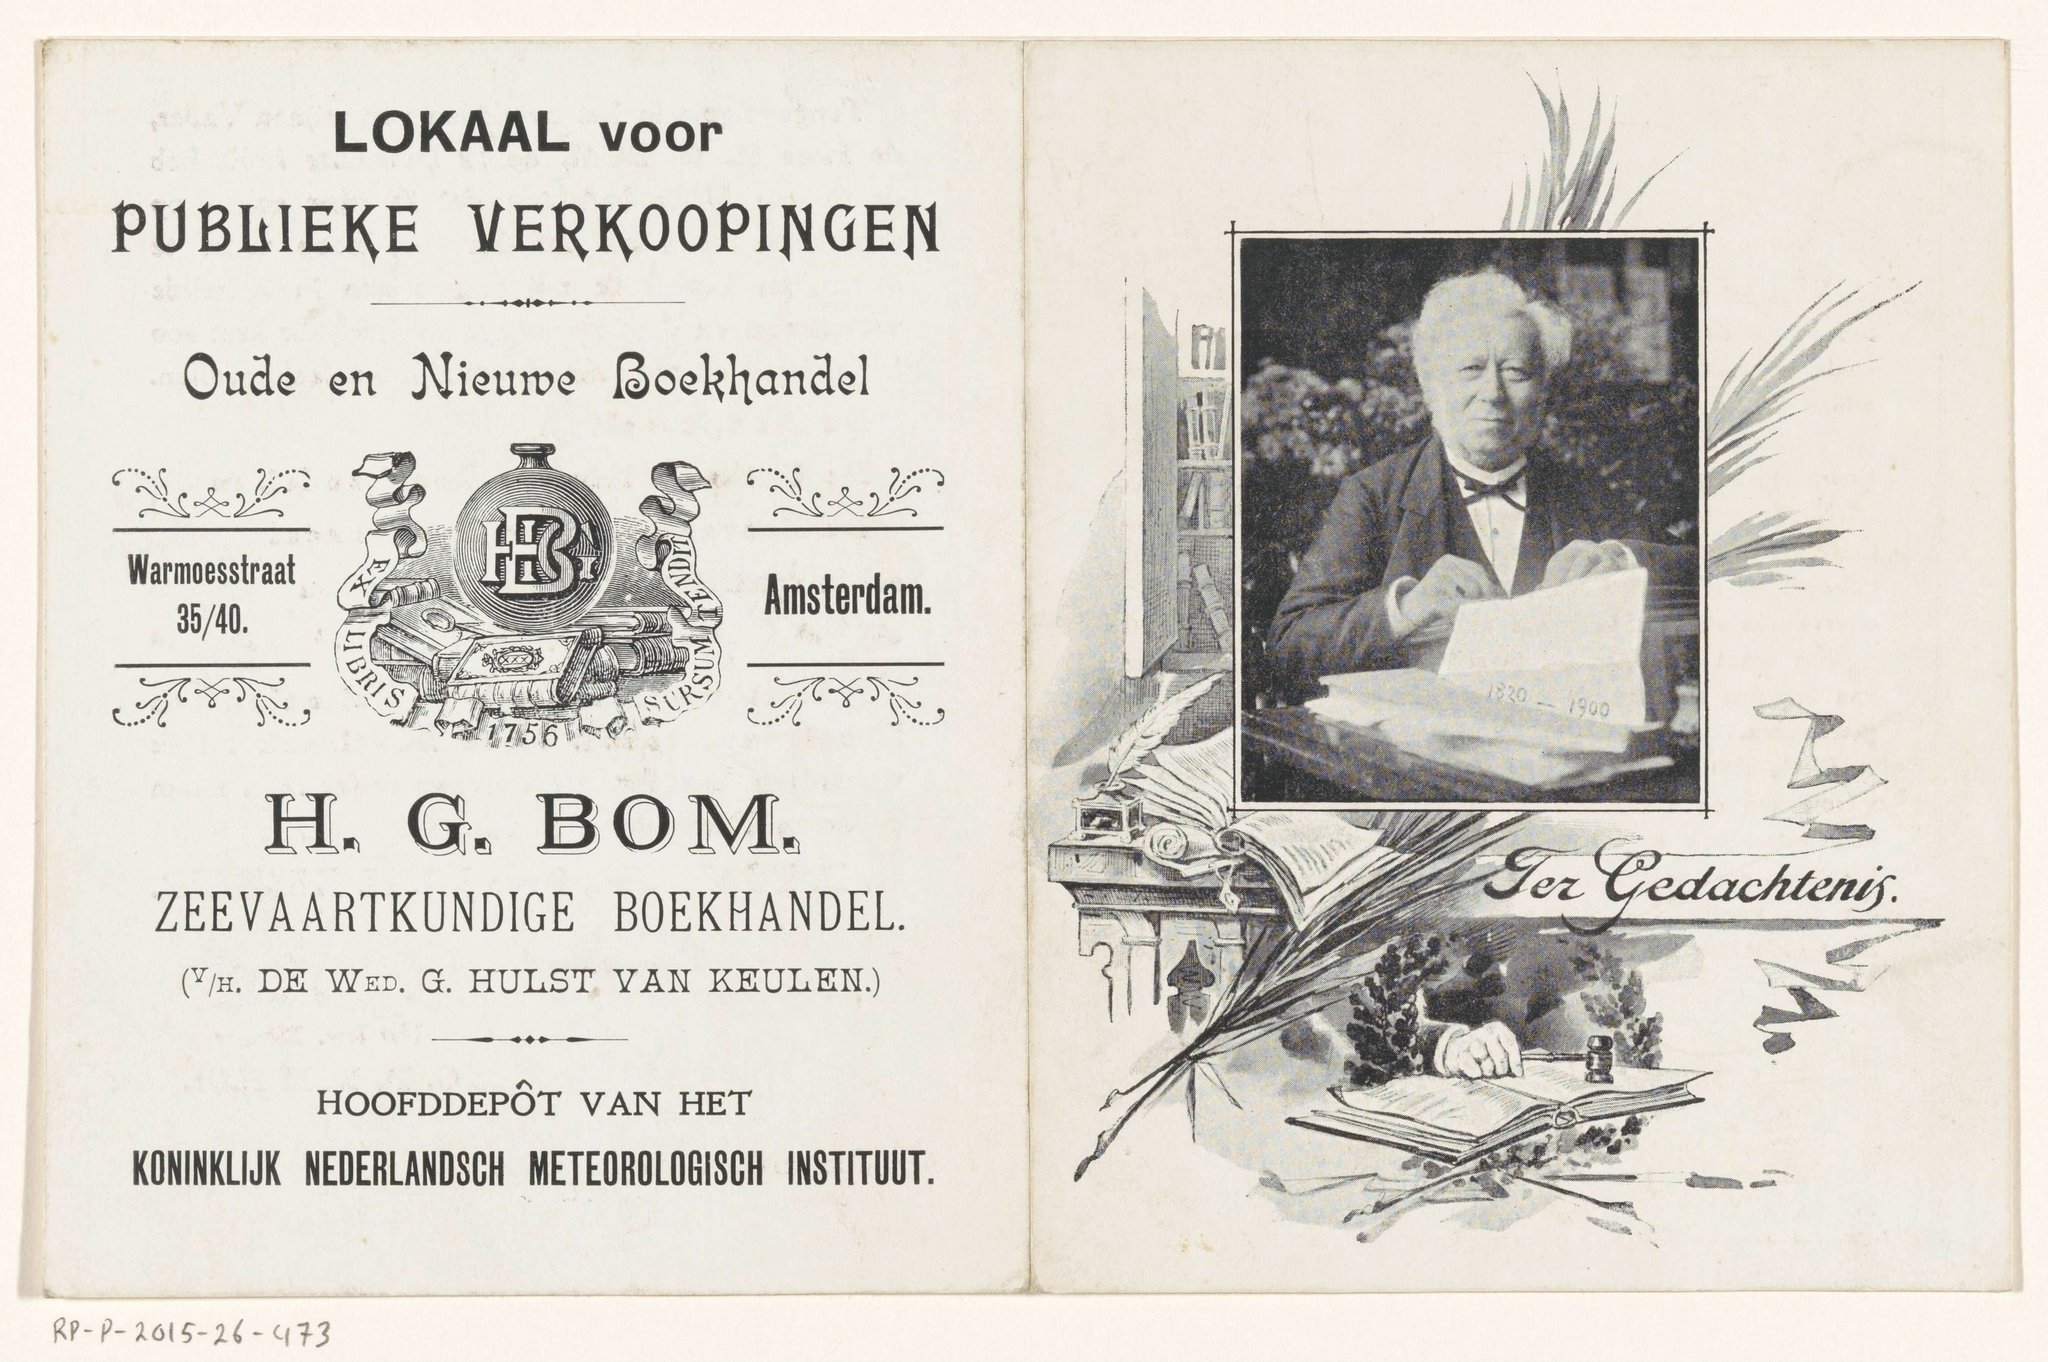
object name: print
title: Portret van Hendricus Gerardus Bom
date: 1901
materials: paper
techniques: letterpress printing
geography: amsterdam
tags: hendricus gerardus bom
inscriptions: collector's mark: Lugt 2228, collector's mark: Lugt 4780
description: Op de voorzijde van een kaart waarin Gerrit Dirk Bom H.Gz. bedankt voor de condoleances naar aanleiding van het overlijden van zijn vader, H.G. Bom, op 12 december 1900. Verder laat hij weten dat hij de zaak van zijn vader zal voortzetten onder de oude naam. Op de achterzijde het adres van de winkel.